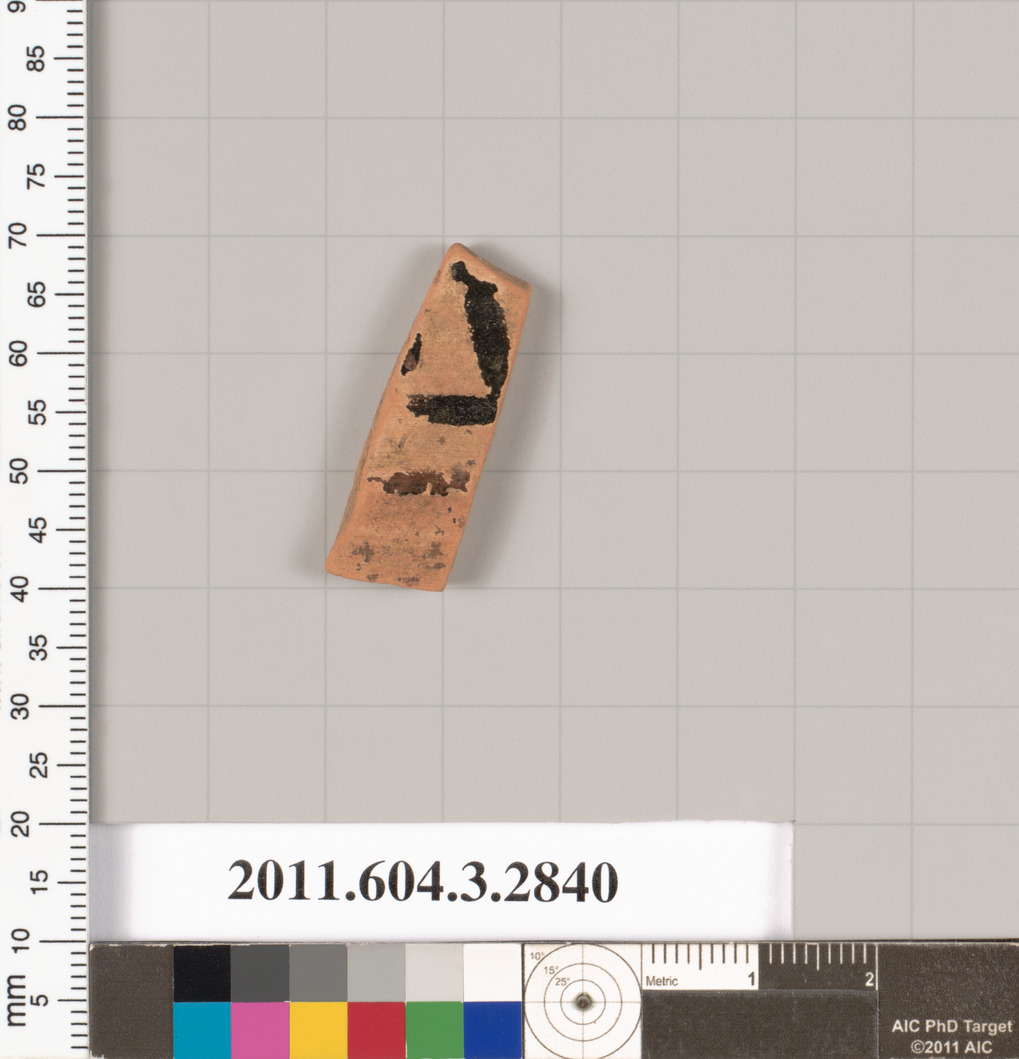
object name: undetermined closed shape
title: Terracotta fragment of a closed shape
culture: greek, attic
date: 534-468 BCE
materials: terracotta